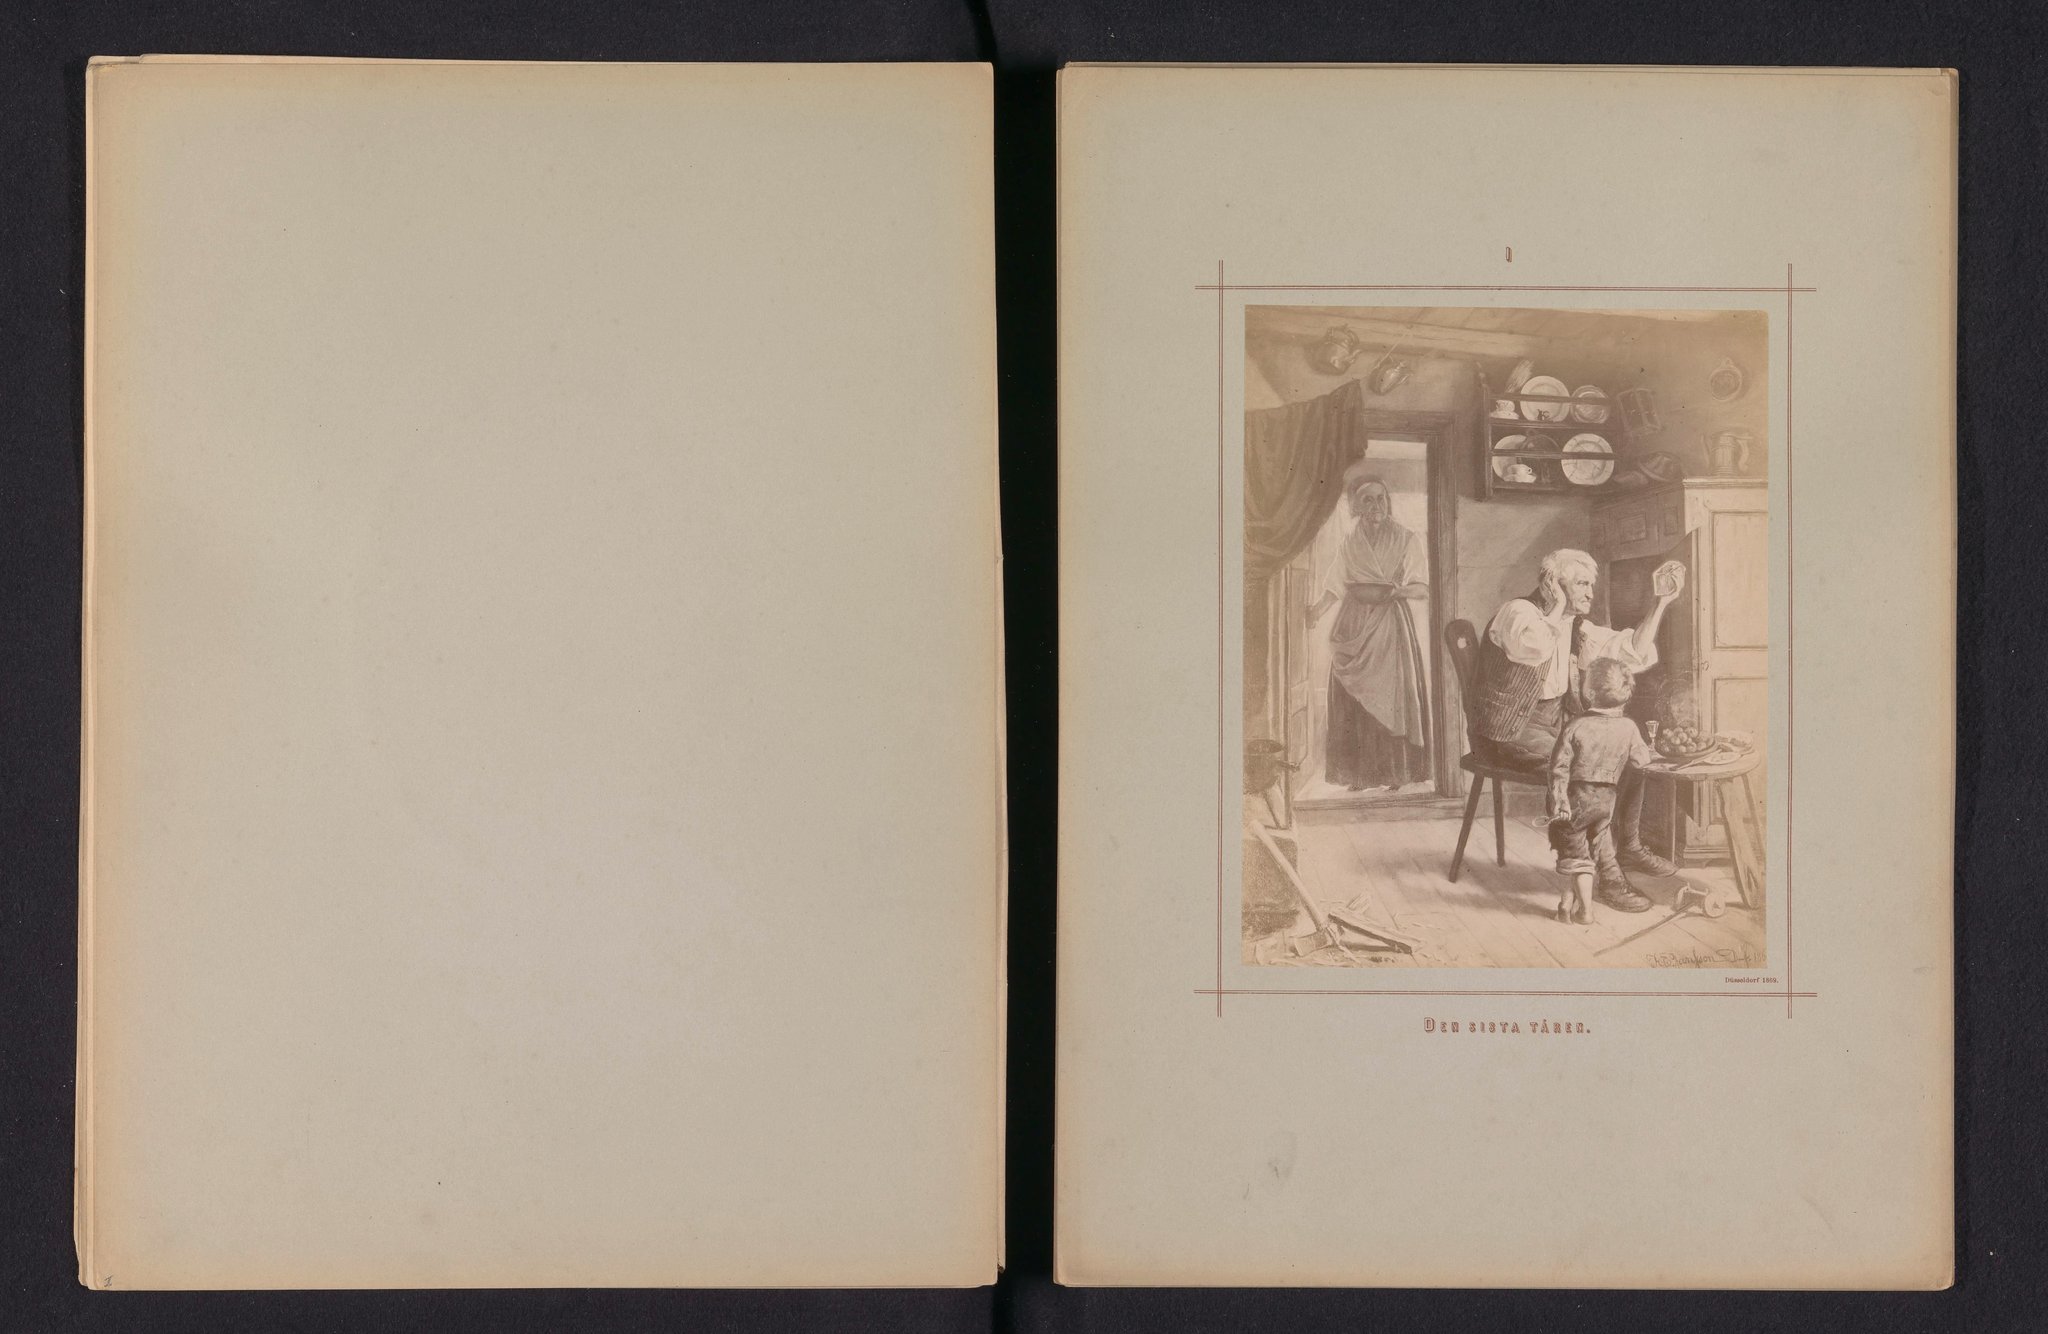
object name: page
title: Den sista tåren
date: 1870-1880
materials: photographic support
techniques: albumen print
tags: interior of the house, container of glass: bottle, jar, vase, picture, painting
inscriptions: number: ‘I’, inscription: ‘Düsseldorf 1869.’